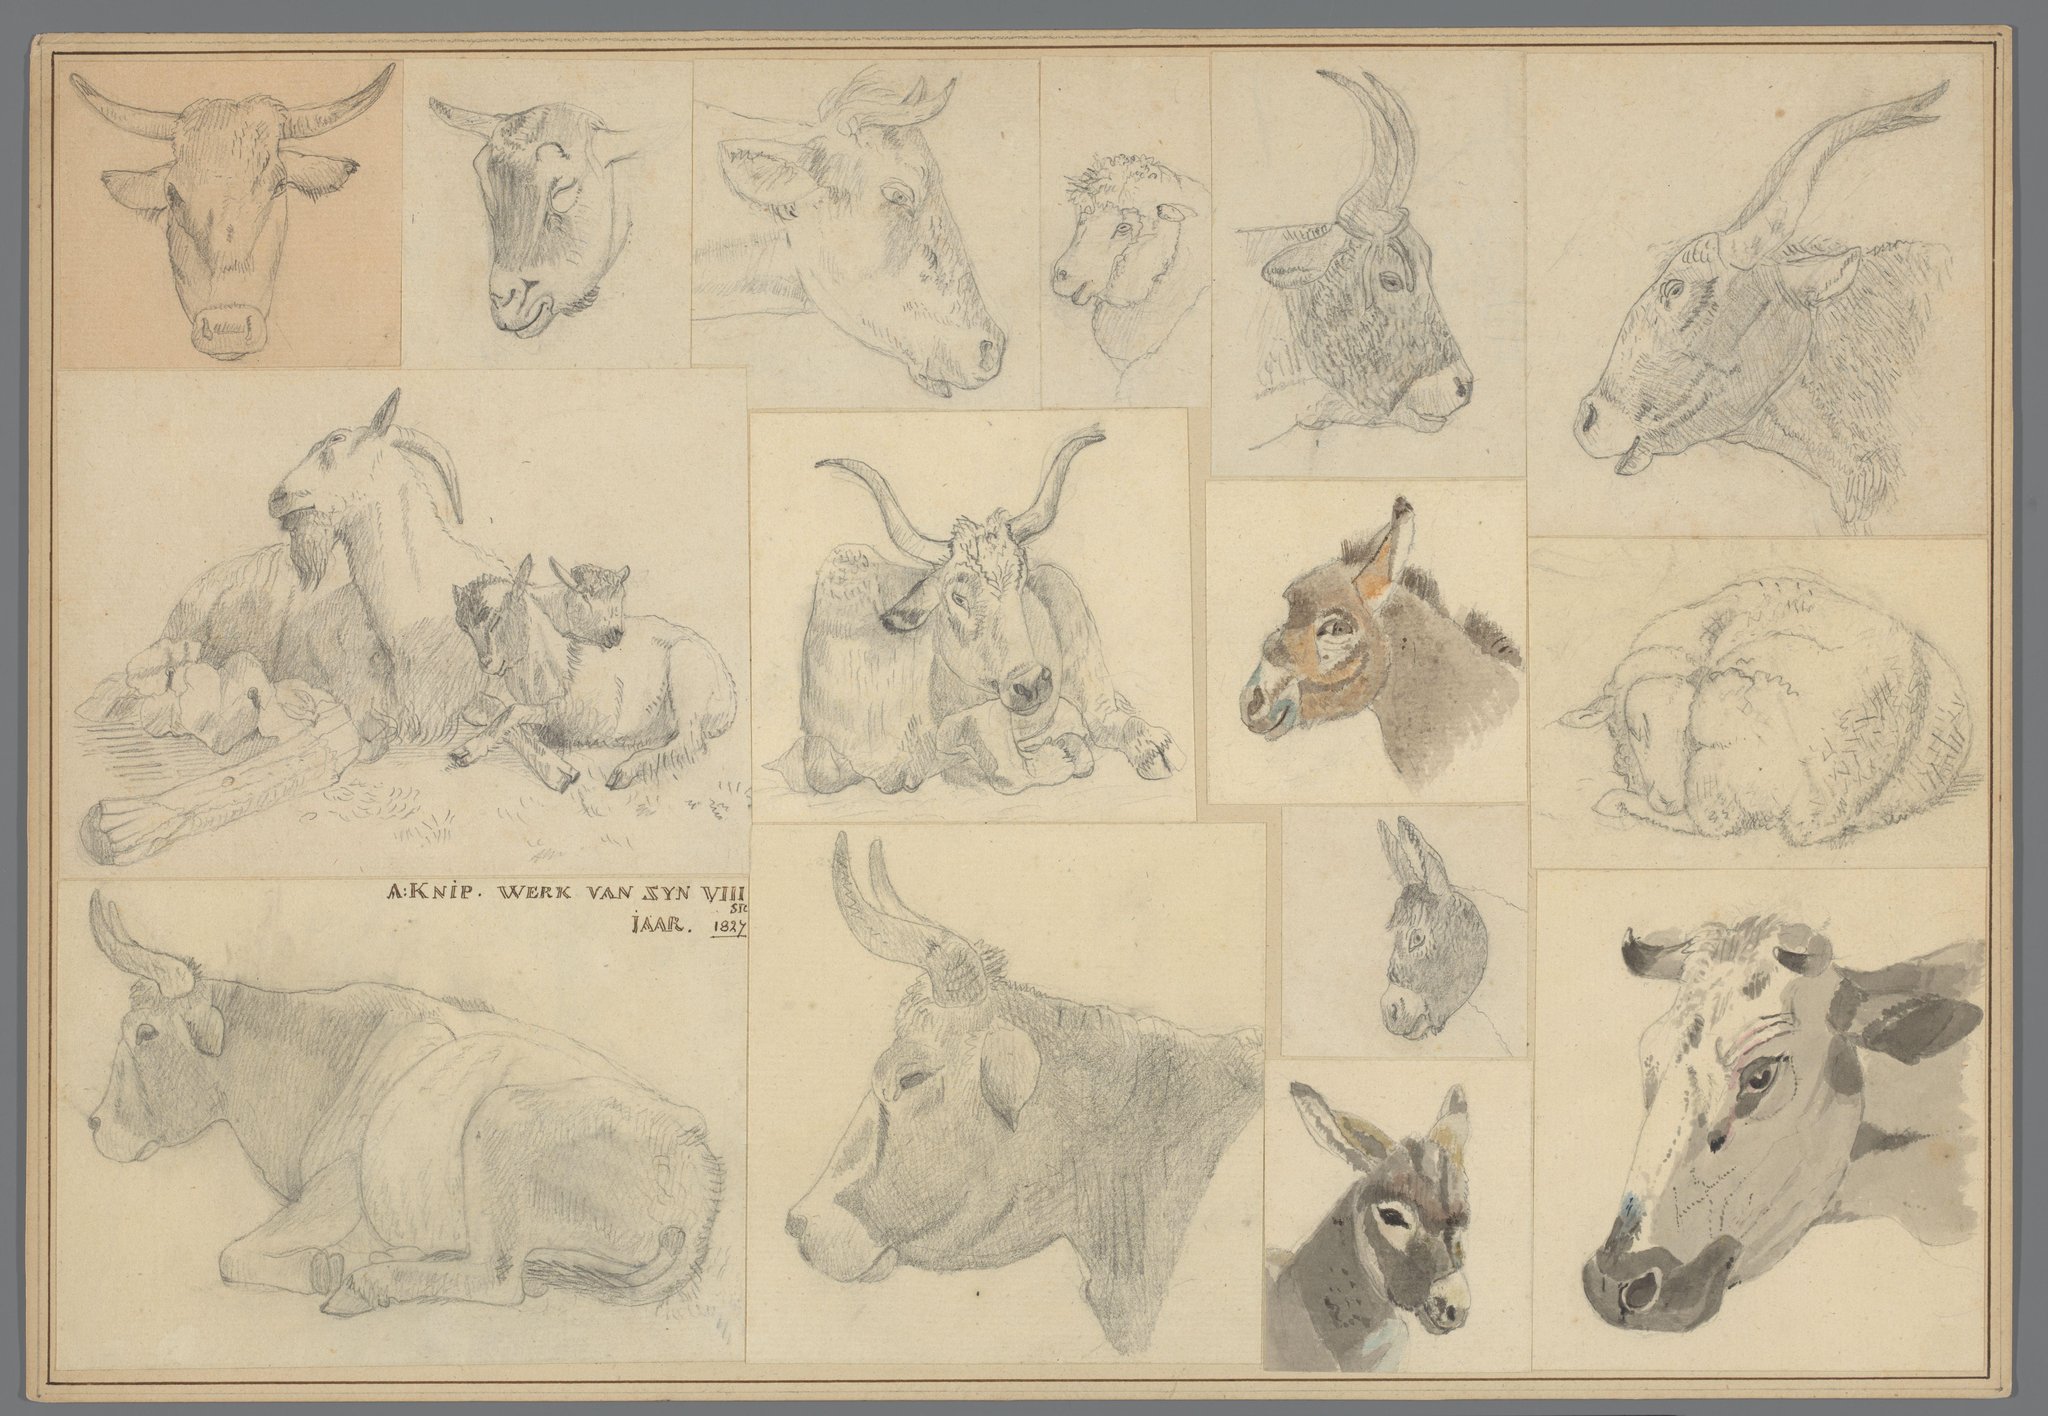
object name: kindertekening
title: Karton waarop 21 kindertekeningen van dieren geplakt zijn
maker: augustus knip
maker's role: painter, print maker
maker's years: 1819-1861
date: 1827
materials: cardboard, ink, paper, pencil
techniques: pen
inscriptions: signature and date: ‘"A:Knip. zyn eerst werk naar het leven. in zyn VIIIste jaar. 1827"’